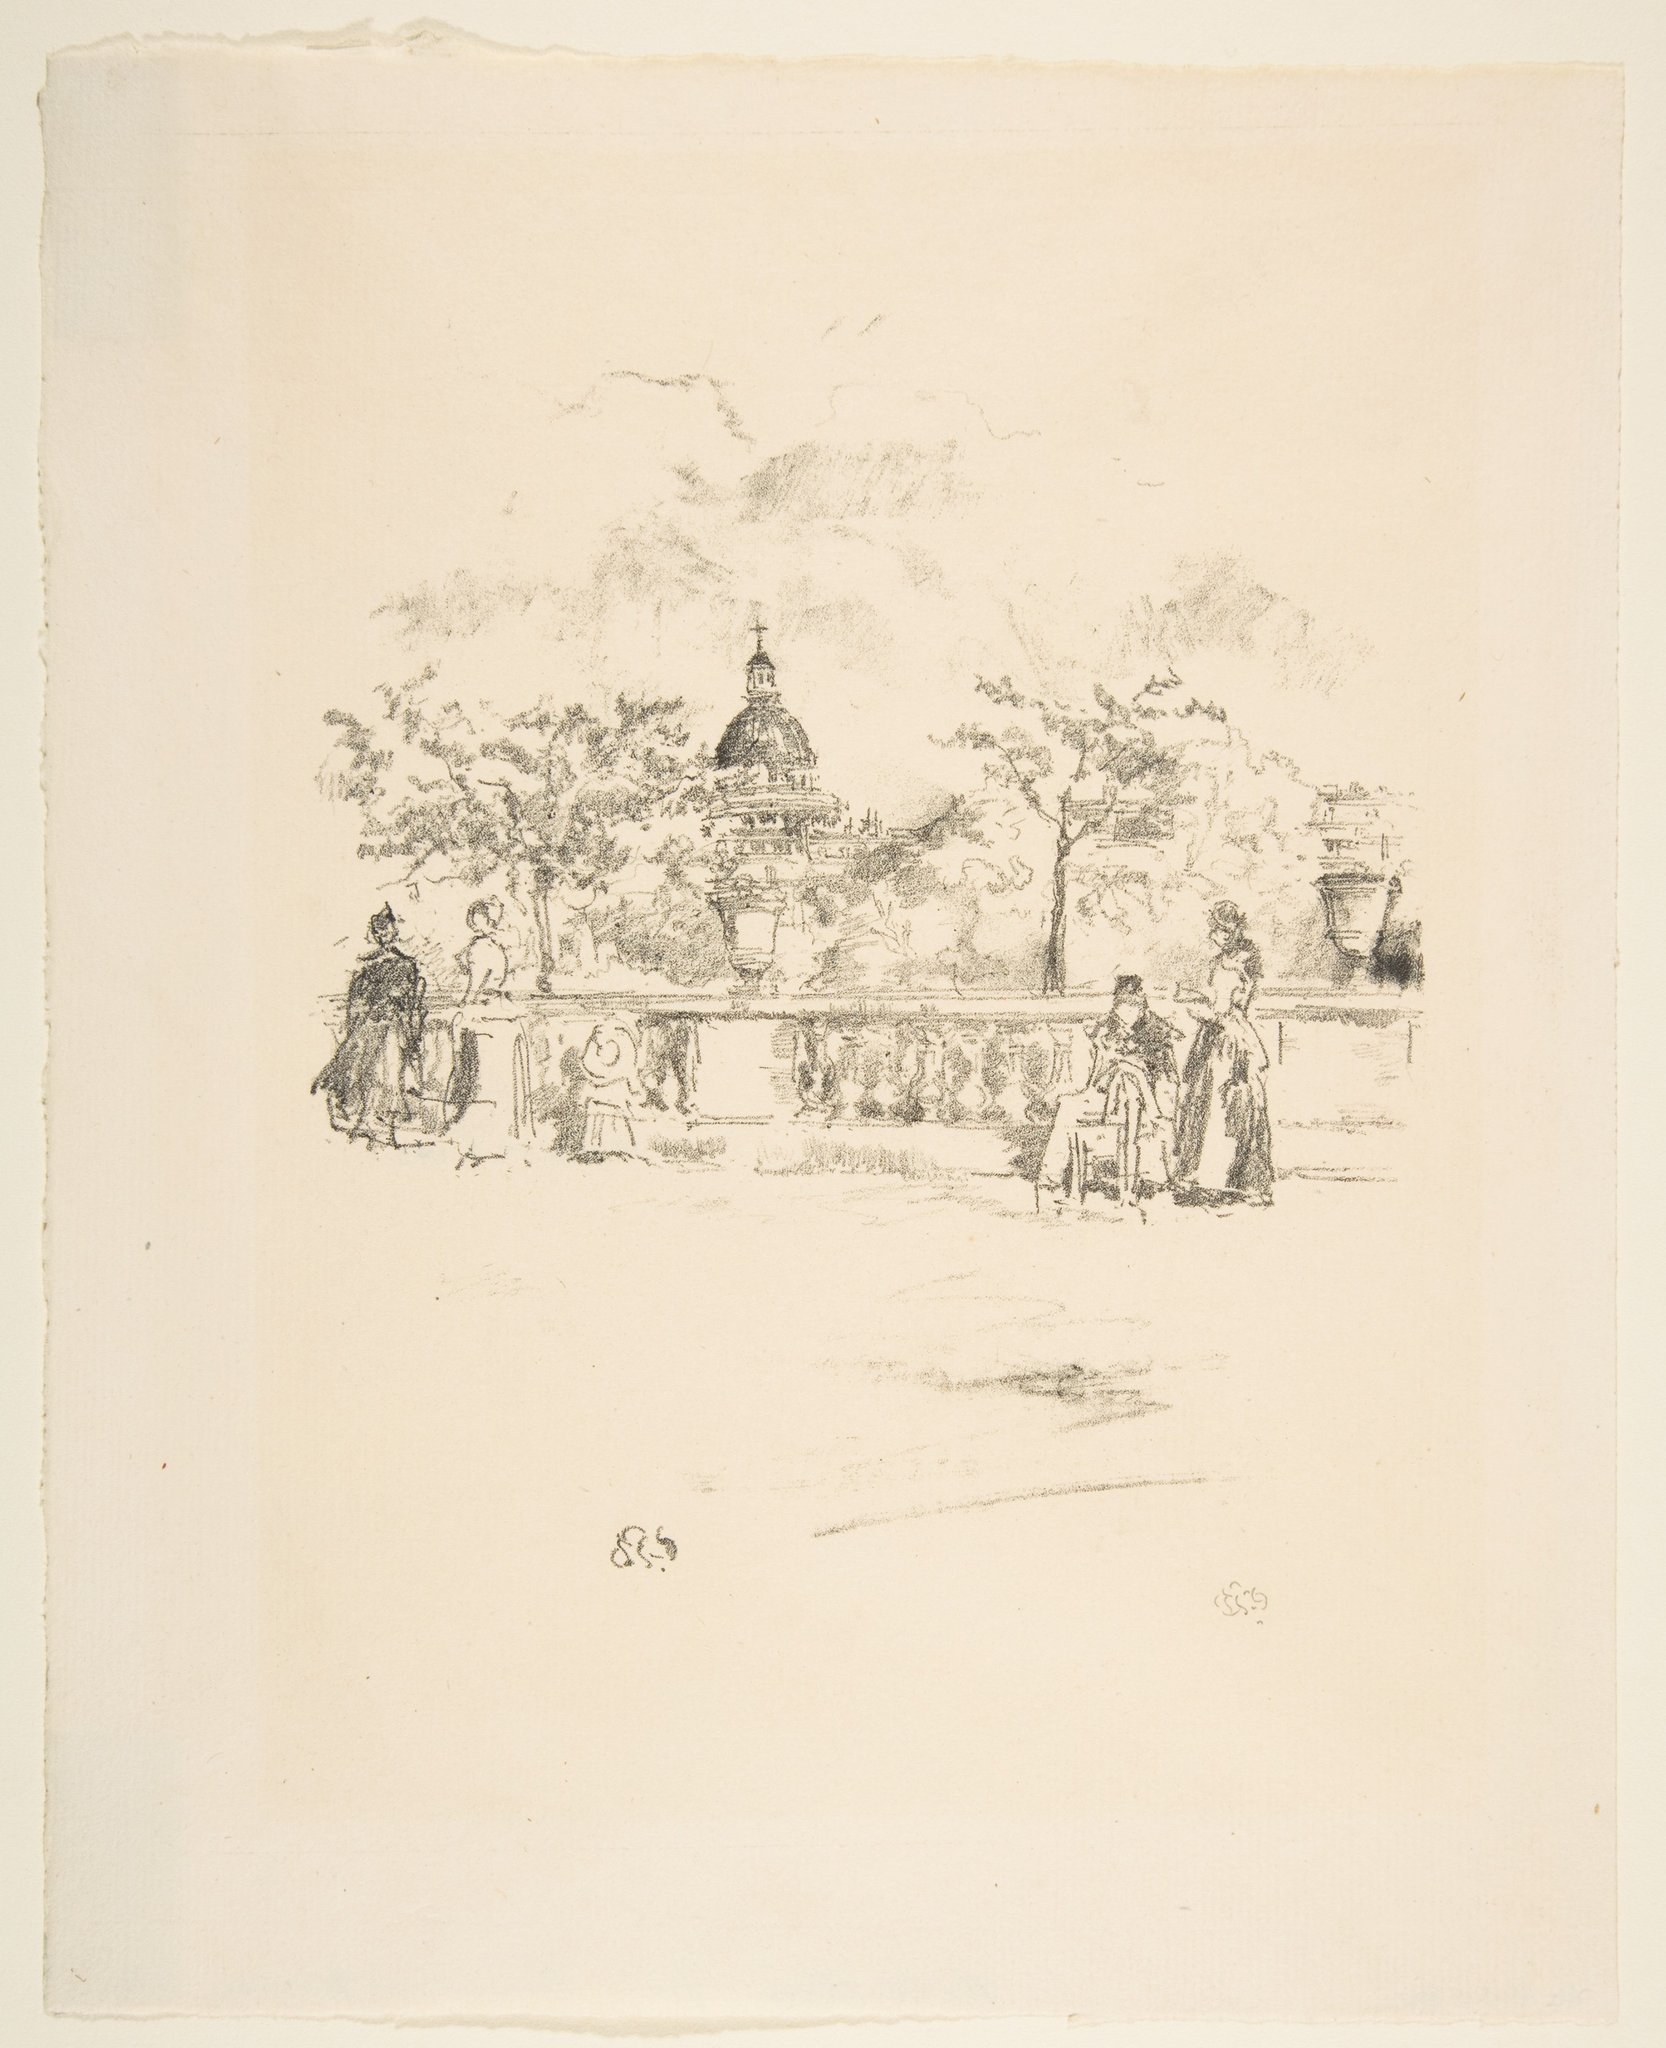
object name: print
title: The Pantheon, from the Terrace of the Luxembourg Gardens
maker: james mcneill whistler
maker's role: artist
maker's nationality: american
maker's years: 1834-1903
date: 1893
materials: ink, paper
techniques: printing, stumping, lithography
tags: gardens,churches,women